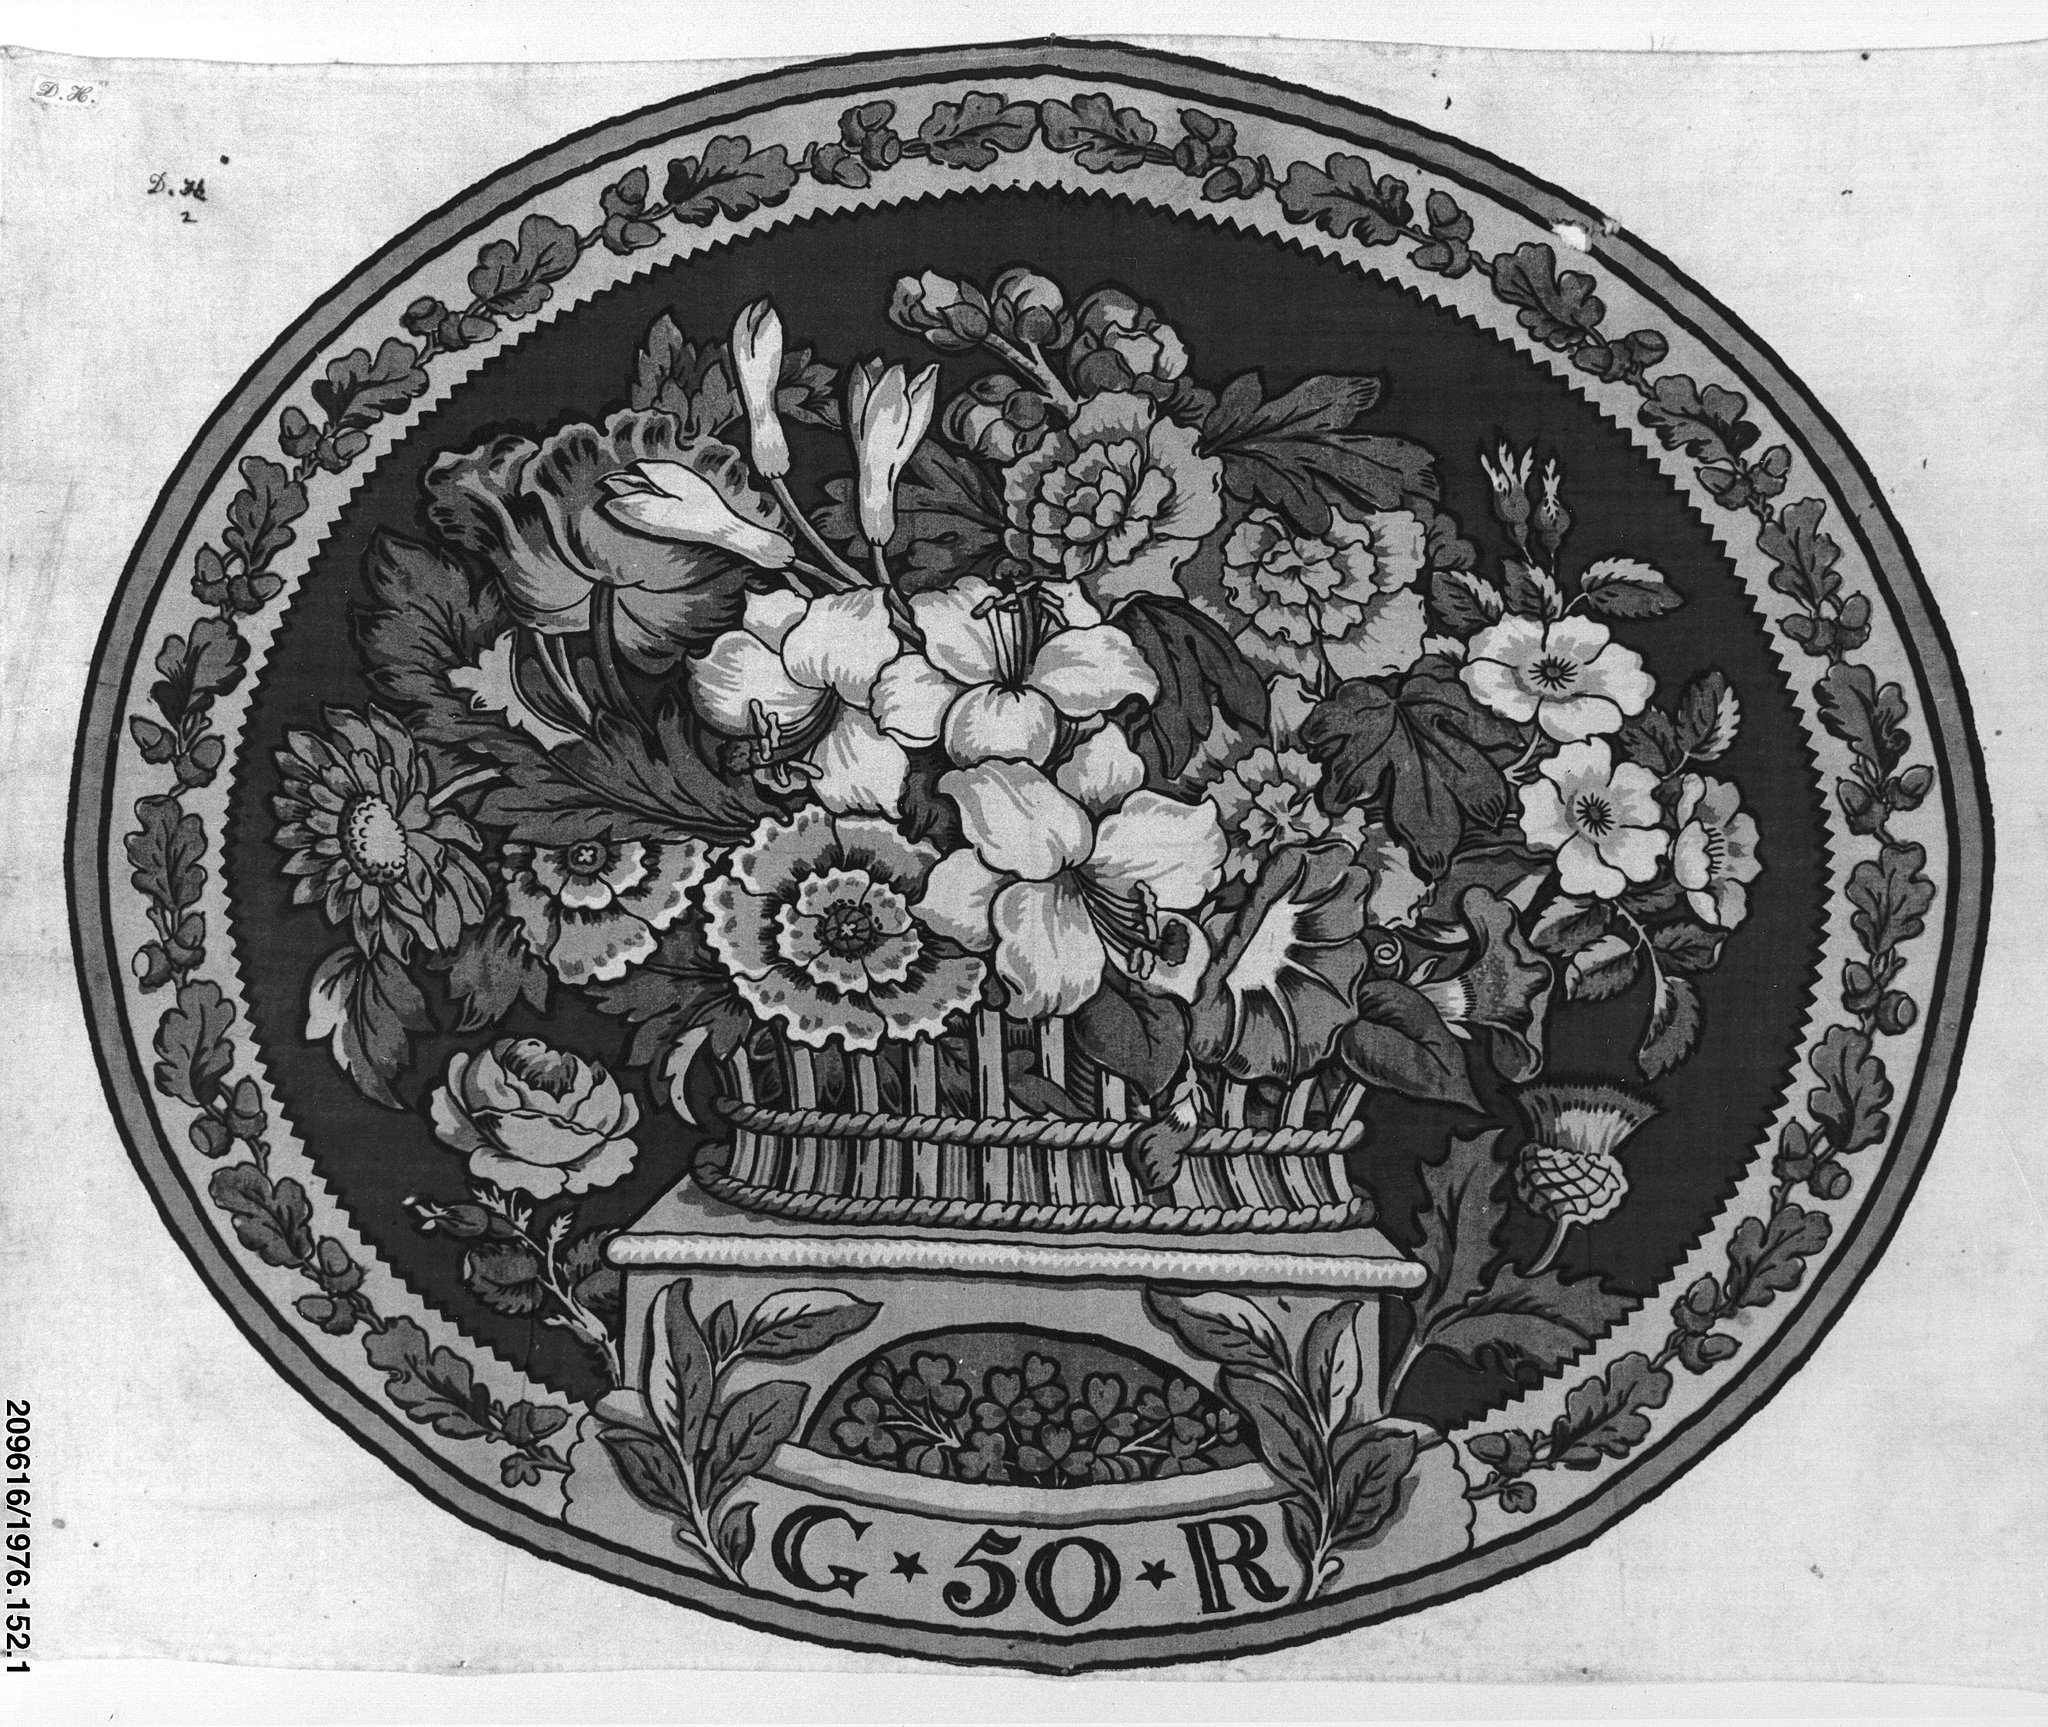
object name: medallion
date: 1810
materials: cotton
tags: flowers,insignia